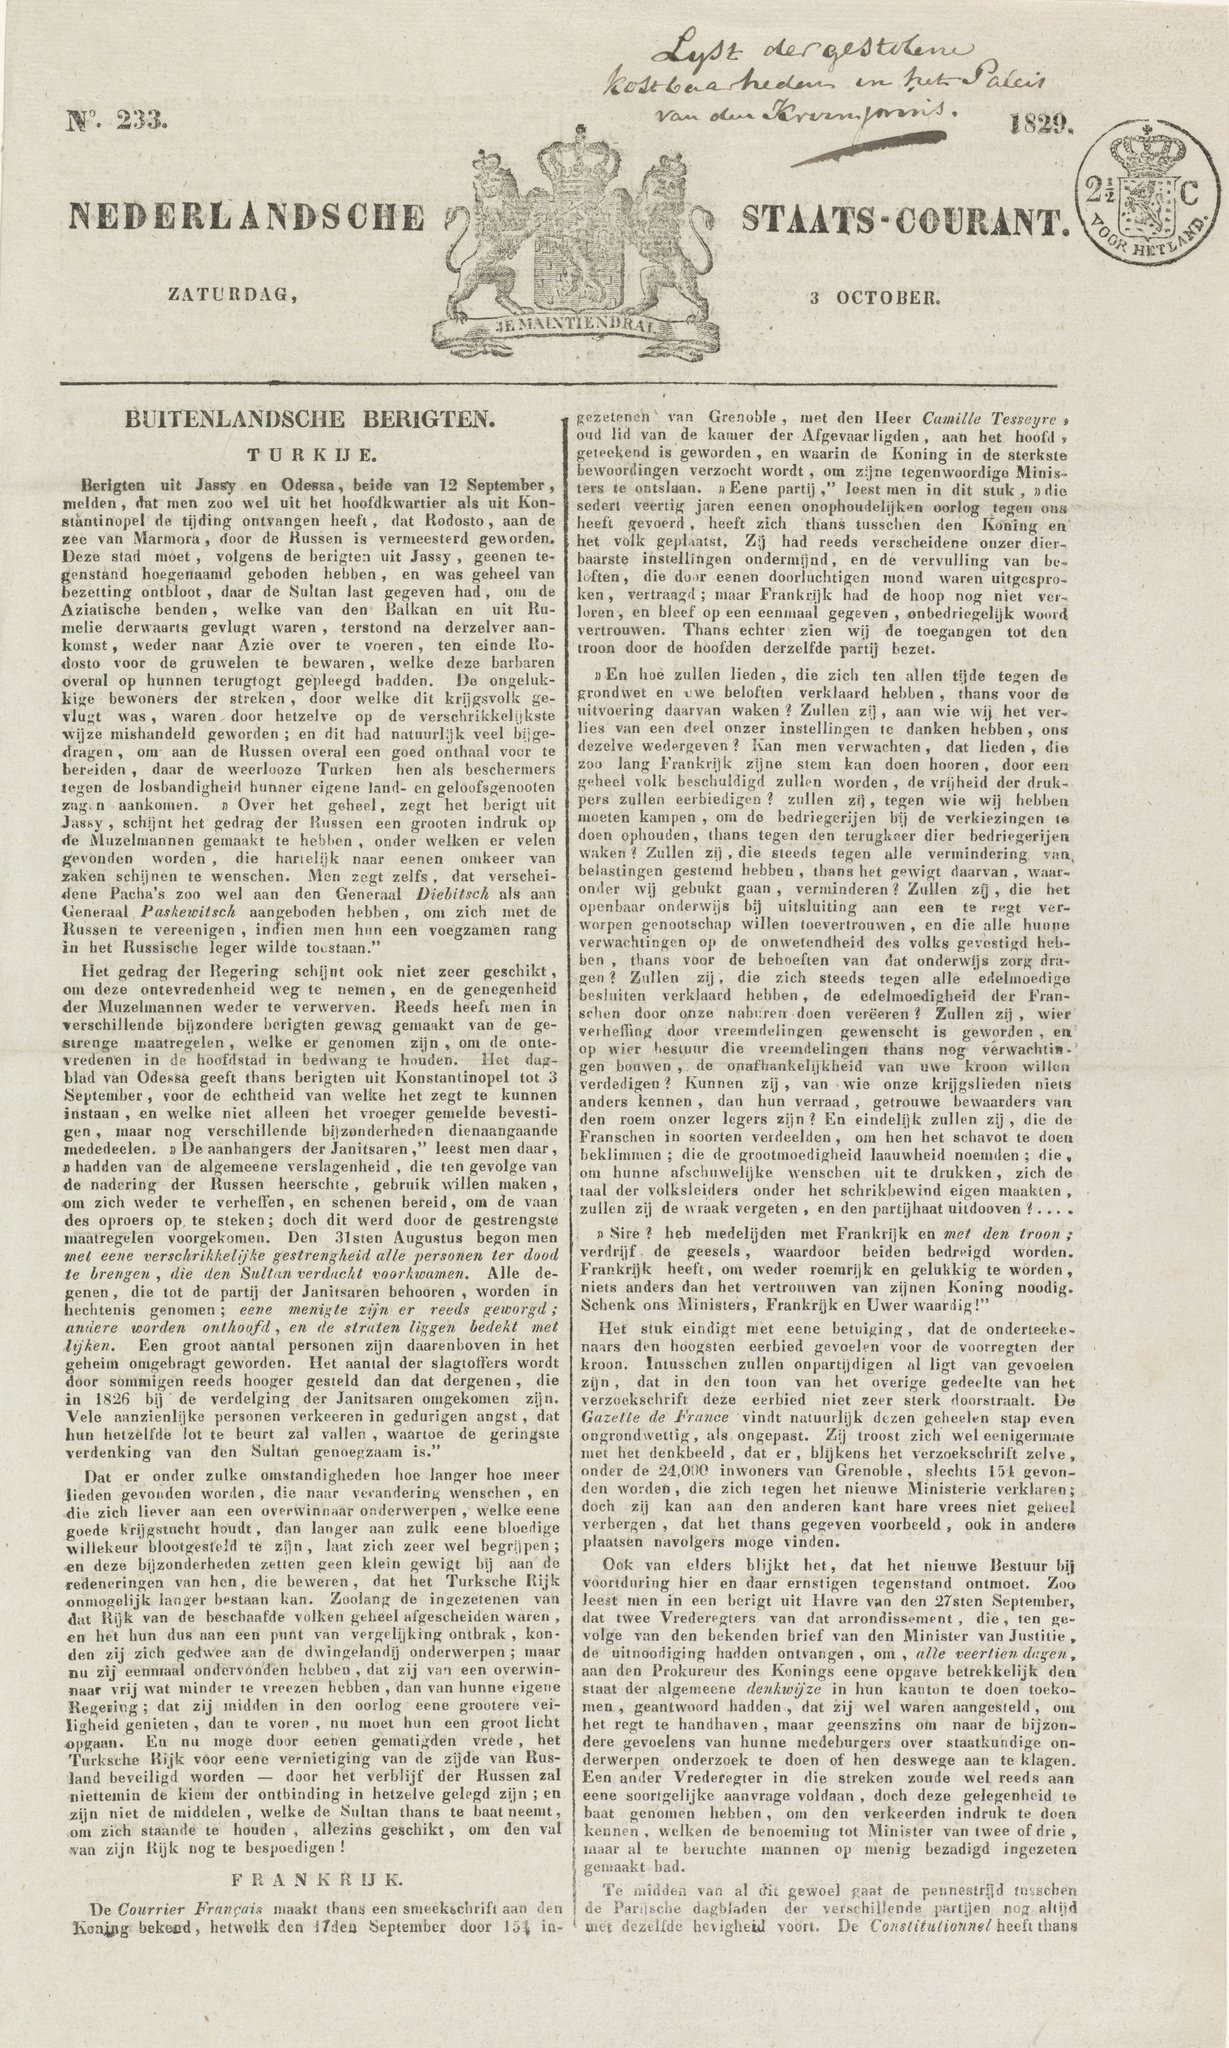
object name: text sheet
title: Staatscourant met lijst van de gestolen juwelen, 3 oktober 1829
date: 1829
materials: paper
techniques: letterpress printing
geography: the hague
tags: anna paulowna romanowa, the hague, william ii of the netherlands, ornaments, jewels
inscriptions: collector's mark: Lugt 2228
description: Exemplaar van de Staatscourant van 3 oktober 1829 met een lijst van de 75 verschillende juwelen en sieraden gestolen uit het paleis van de prins en prinses van Oranje te Brussel op 26 september 1829. Enkel blad met bovenaan het wapen van Nederland.